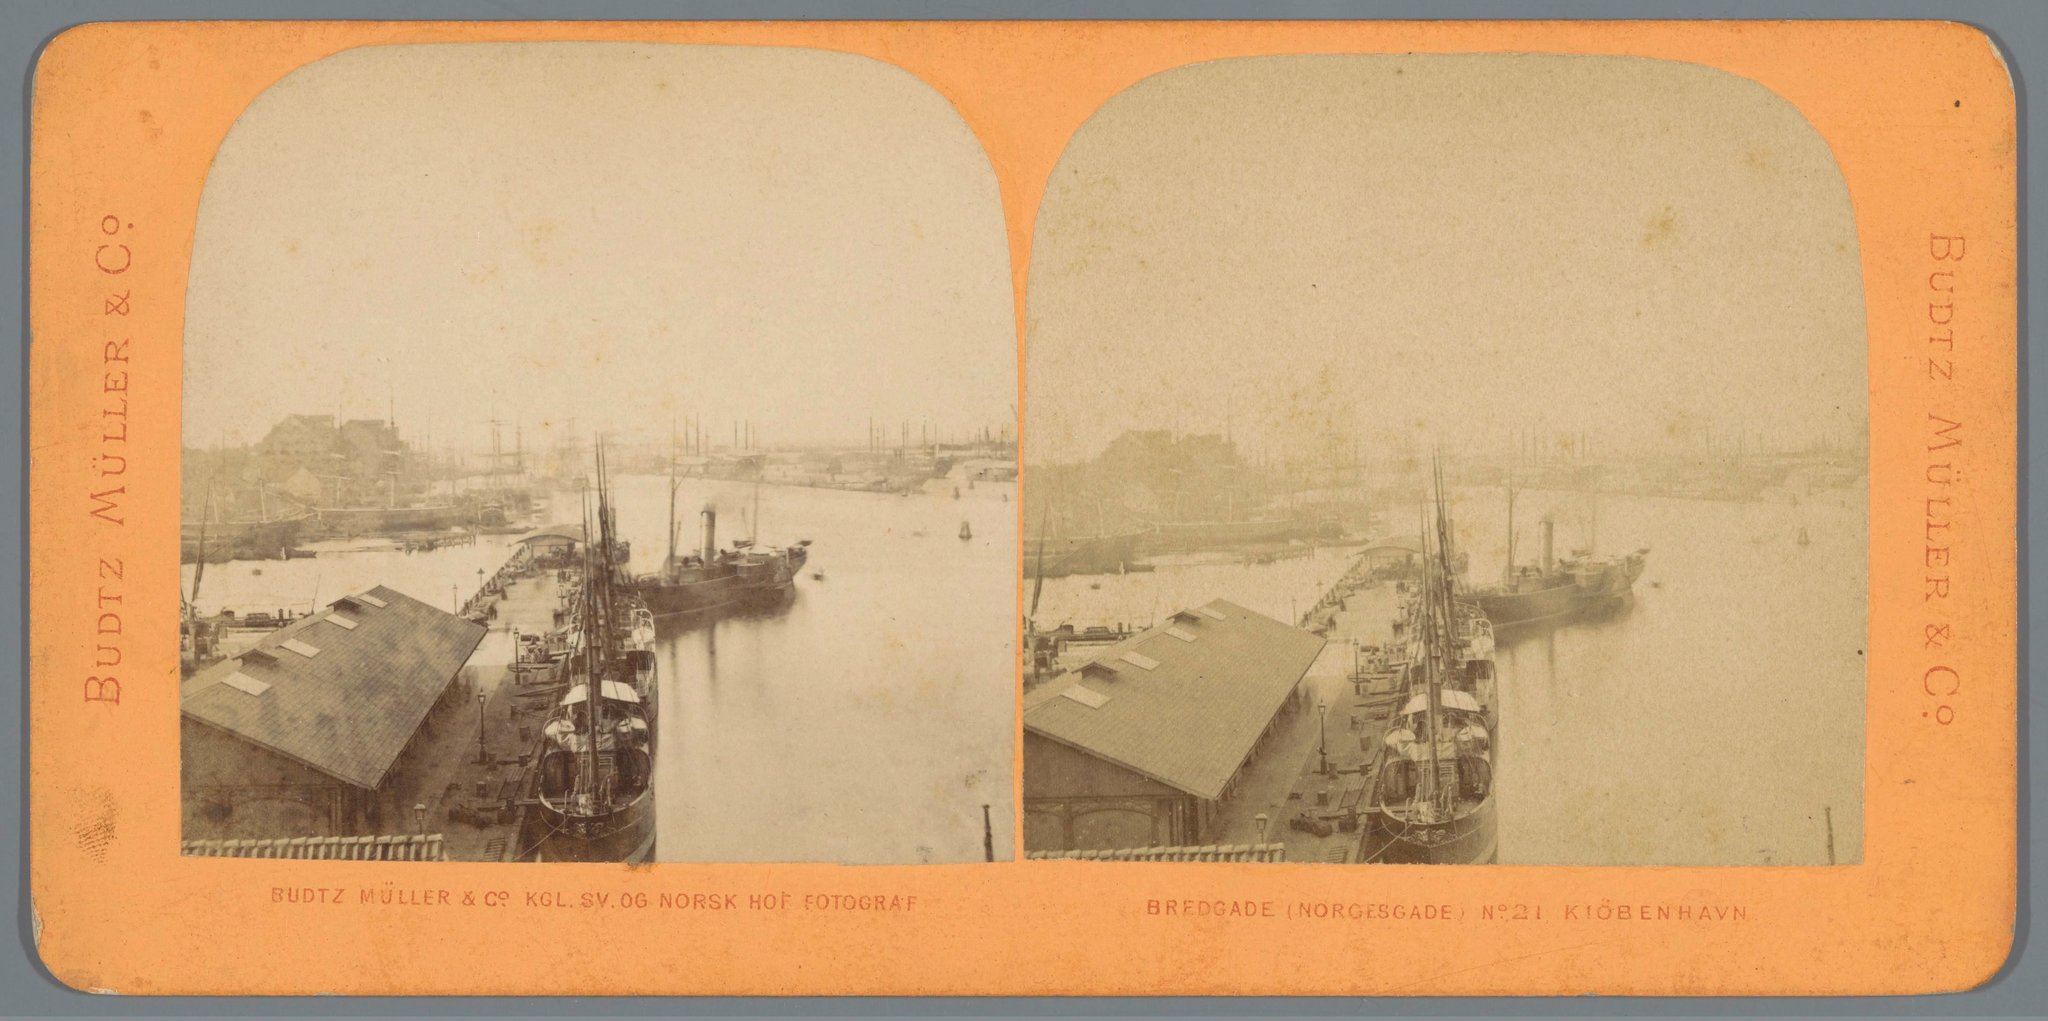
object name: stereograph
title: Kvaesthusbroen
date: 1873-1890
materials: cardboard, paper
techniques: albumen print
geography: copenhagen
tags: ships (in general) - cc - more than one ship, pier, quay, wharf, copenhagen (city)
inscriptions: address: ‘BREDGADE (NORGESGADE) No. 21 KJÖBENHAVN’